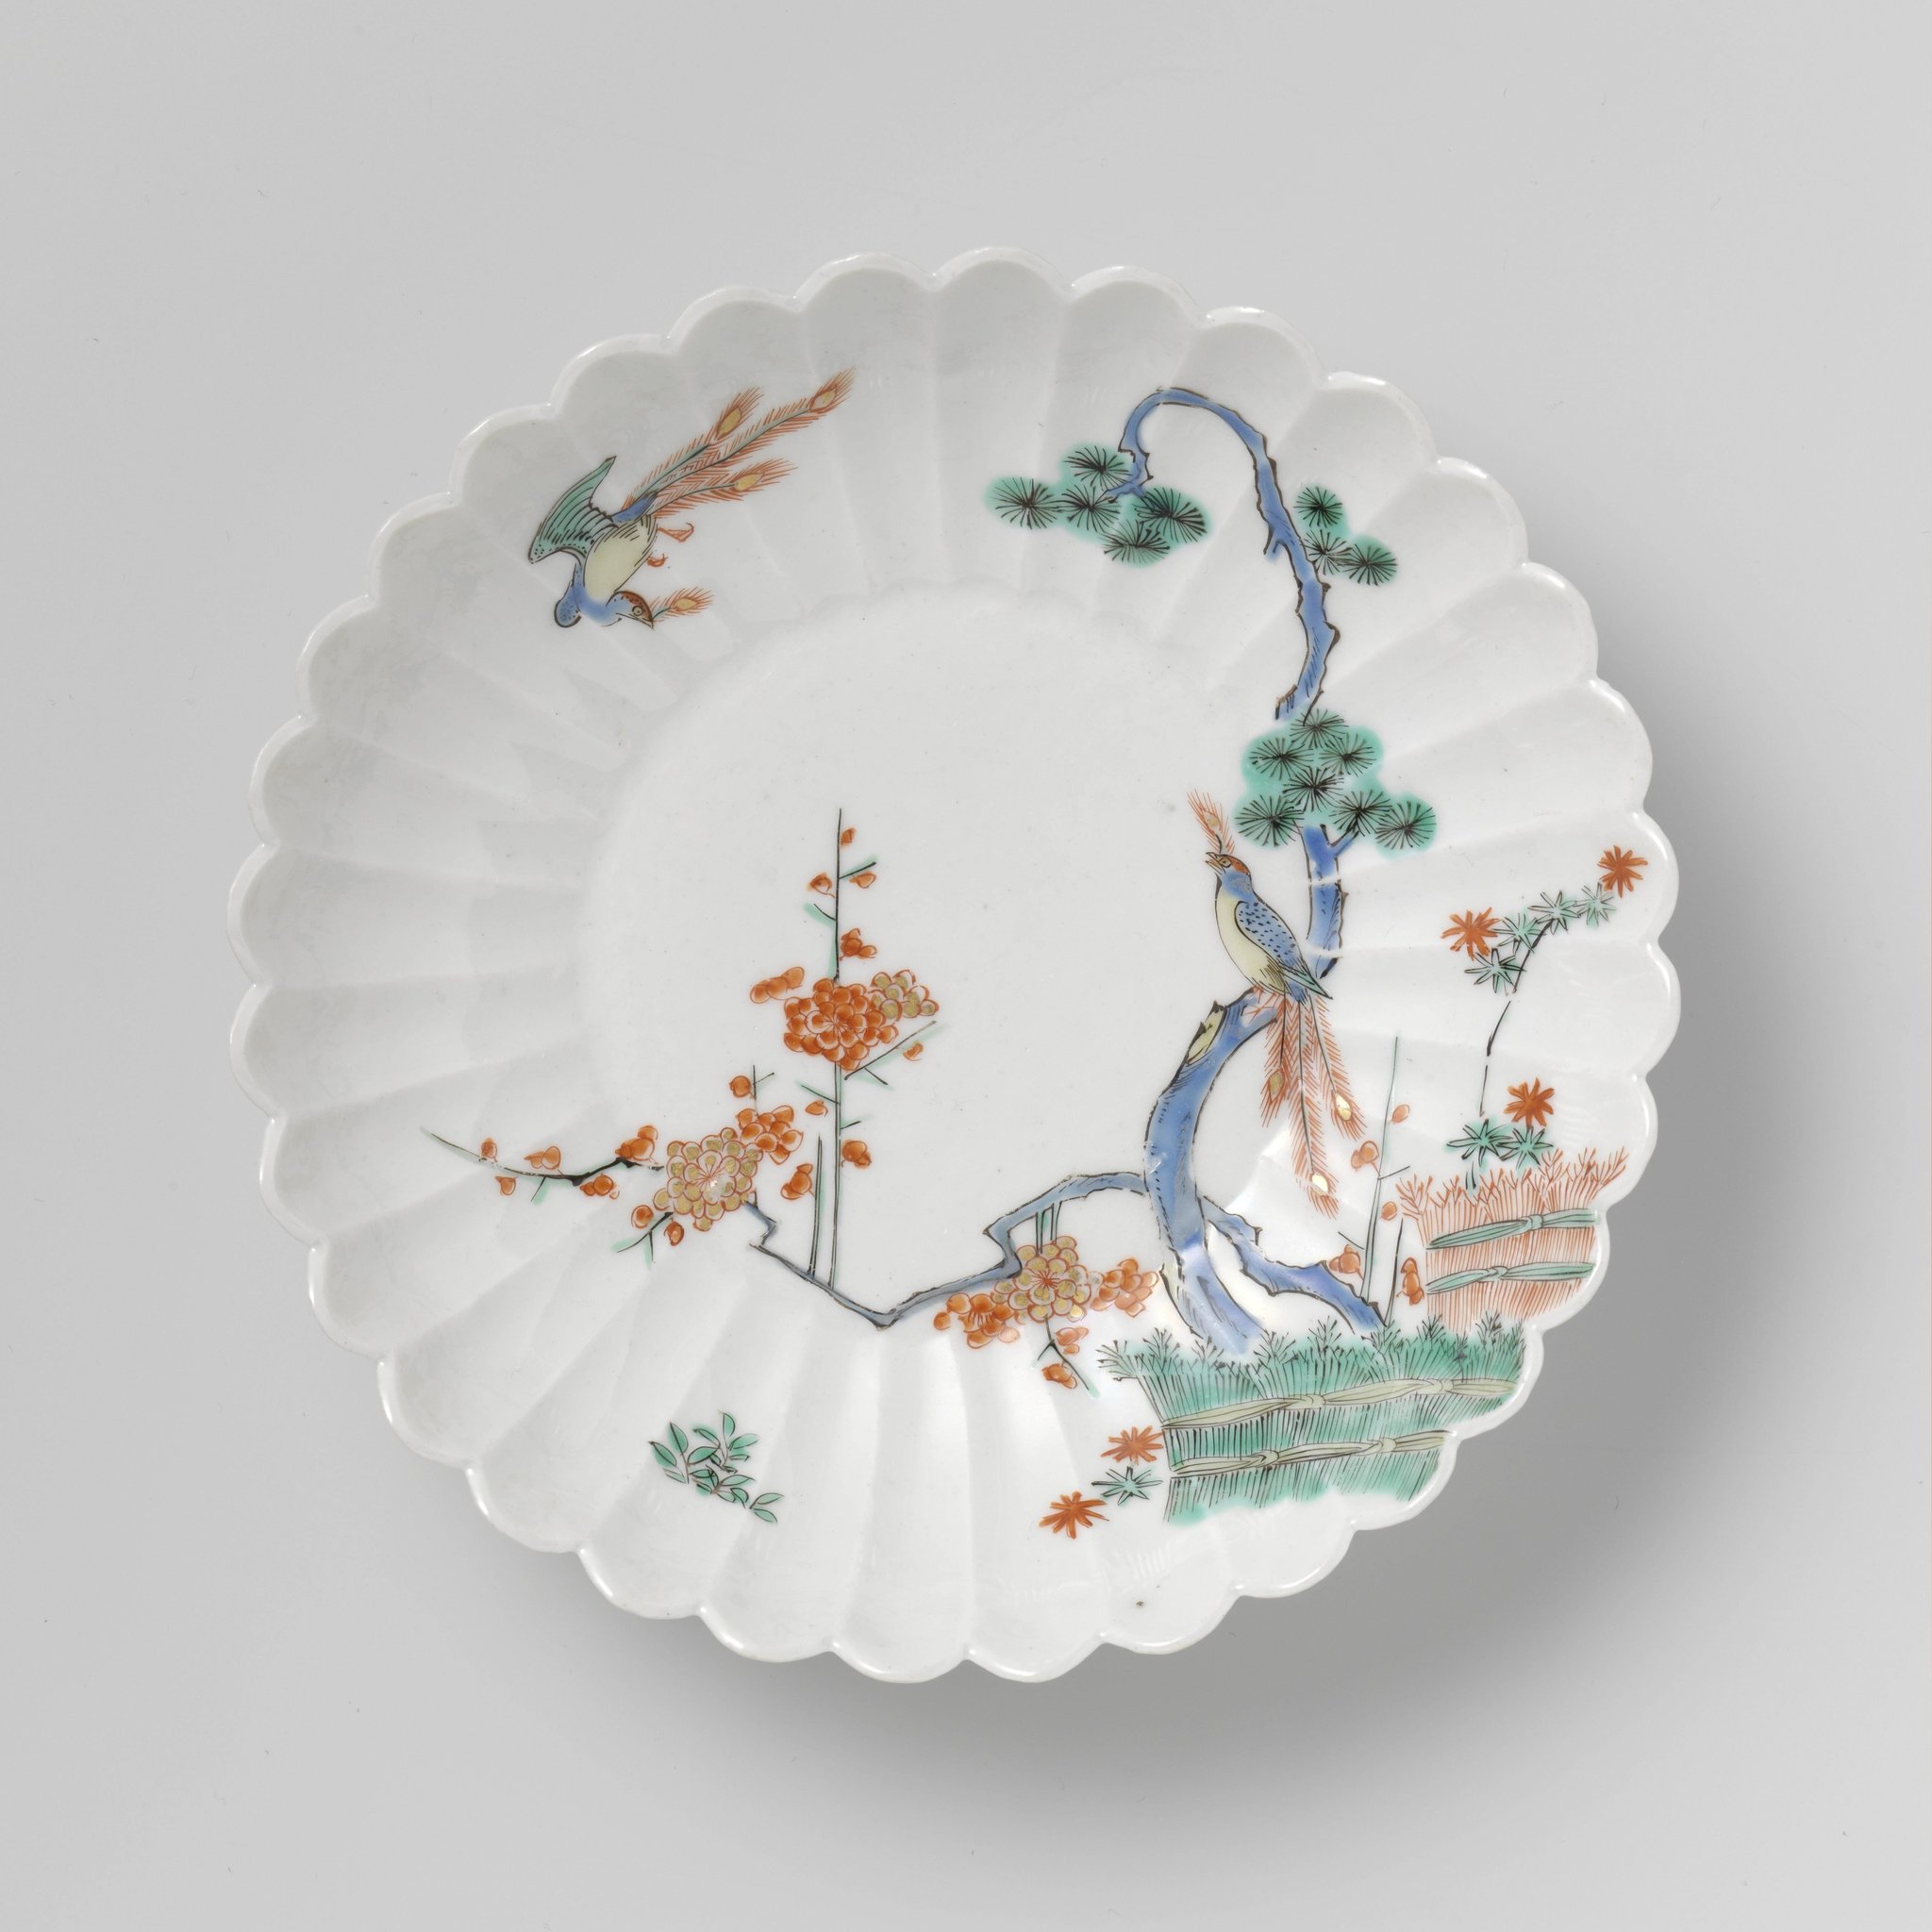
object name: dish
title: Saucer-dish with the 'three friends' near brushwood fences and two hoo-birds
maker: Anonymous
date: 1670-1690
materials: glaze, gold, paint, porcelain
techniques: firing, forming, gilding, turning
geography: japan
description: Small dish decorated with 'the three friends' (pine, prunus and bamboo) c. 1690 - 1710